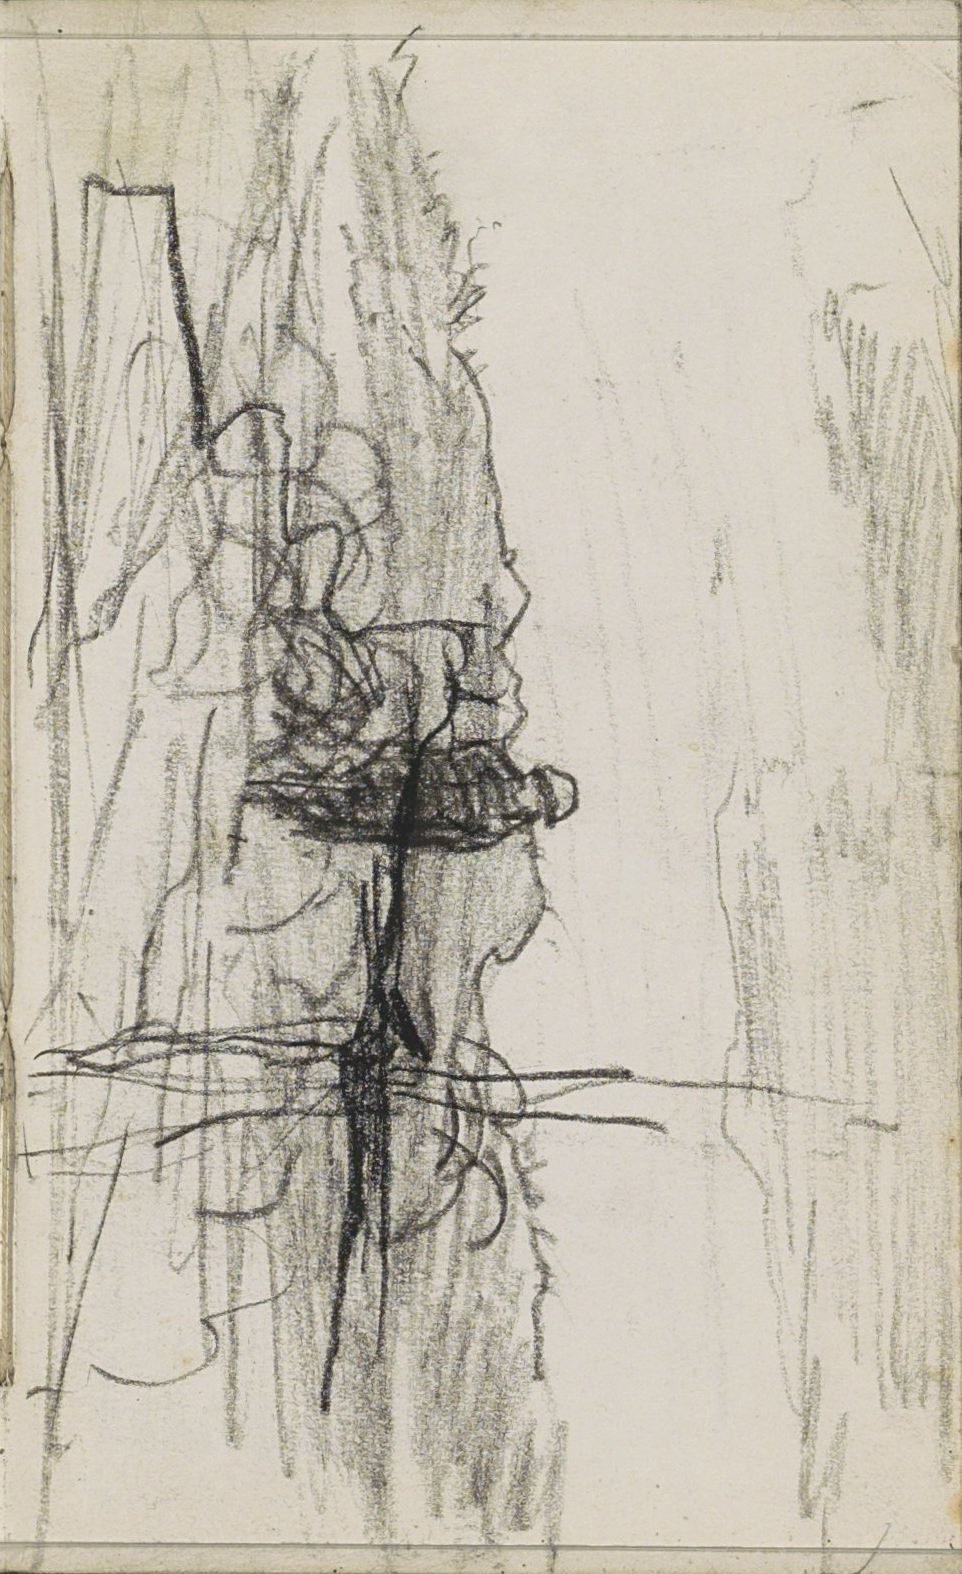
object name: sketchbook leaf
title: Man op het land, mogelijk een arbeider of boer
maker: anton mauve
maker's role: draughtsman, painter, print maker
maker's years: 1838-1888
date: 1848-1888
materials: chalk, paper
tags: landscapes (+ landscape with figures, staffage)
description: Blad 52 recto uit een schetsboek met 53 bladen.